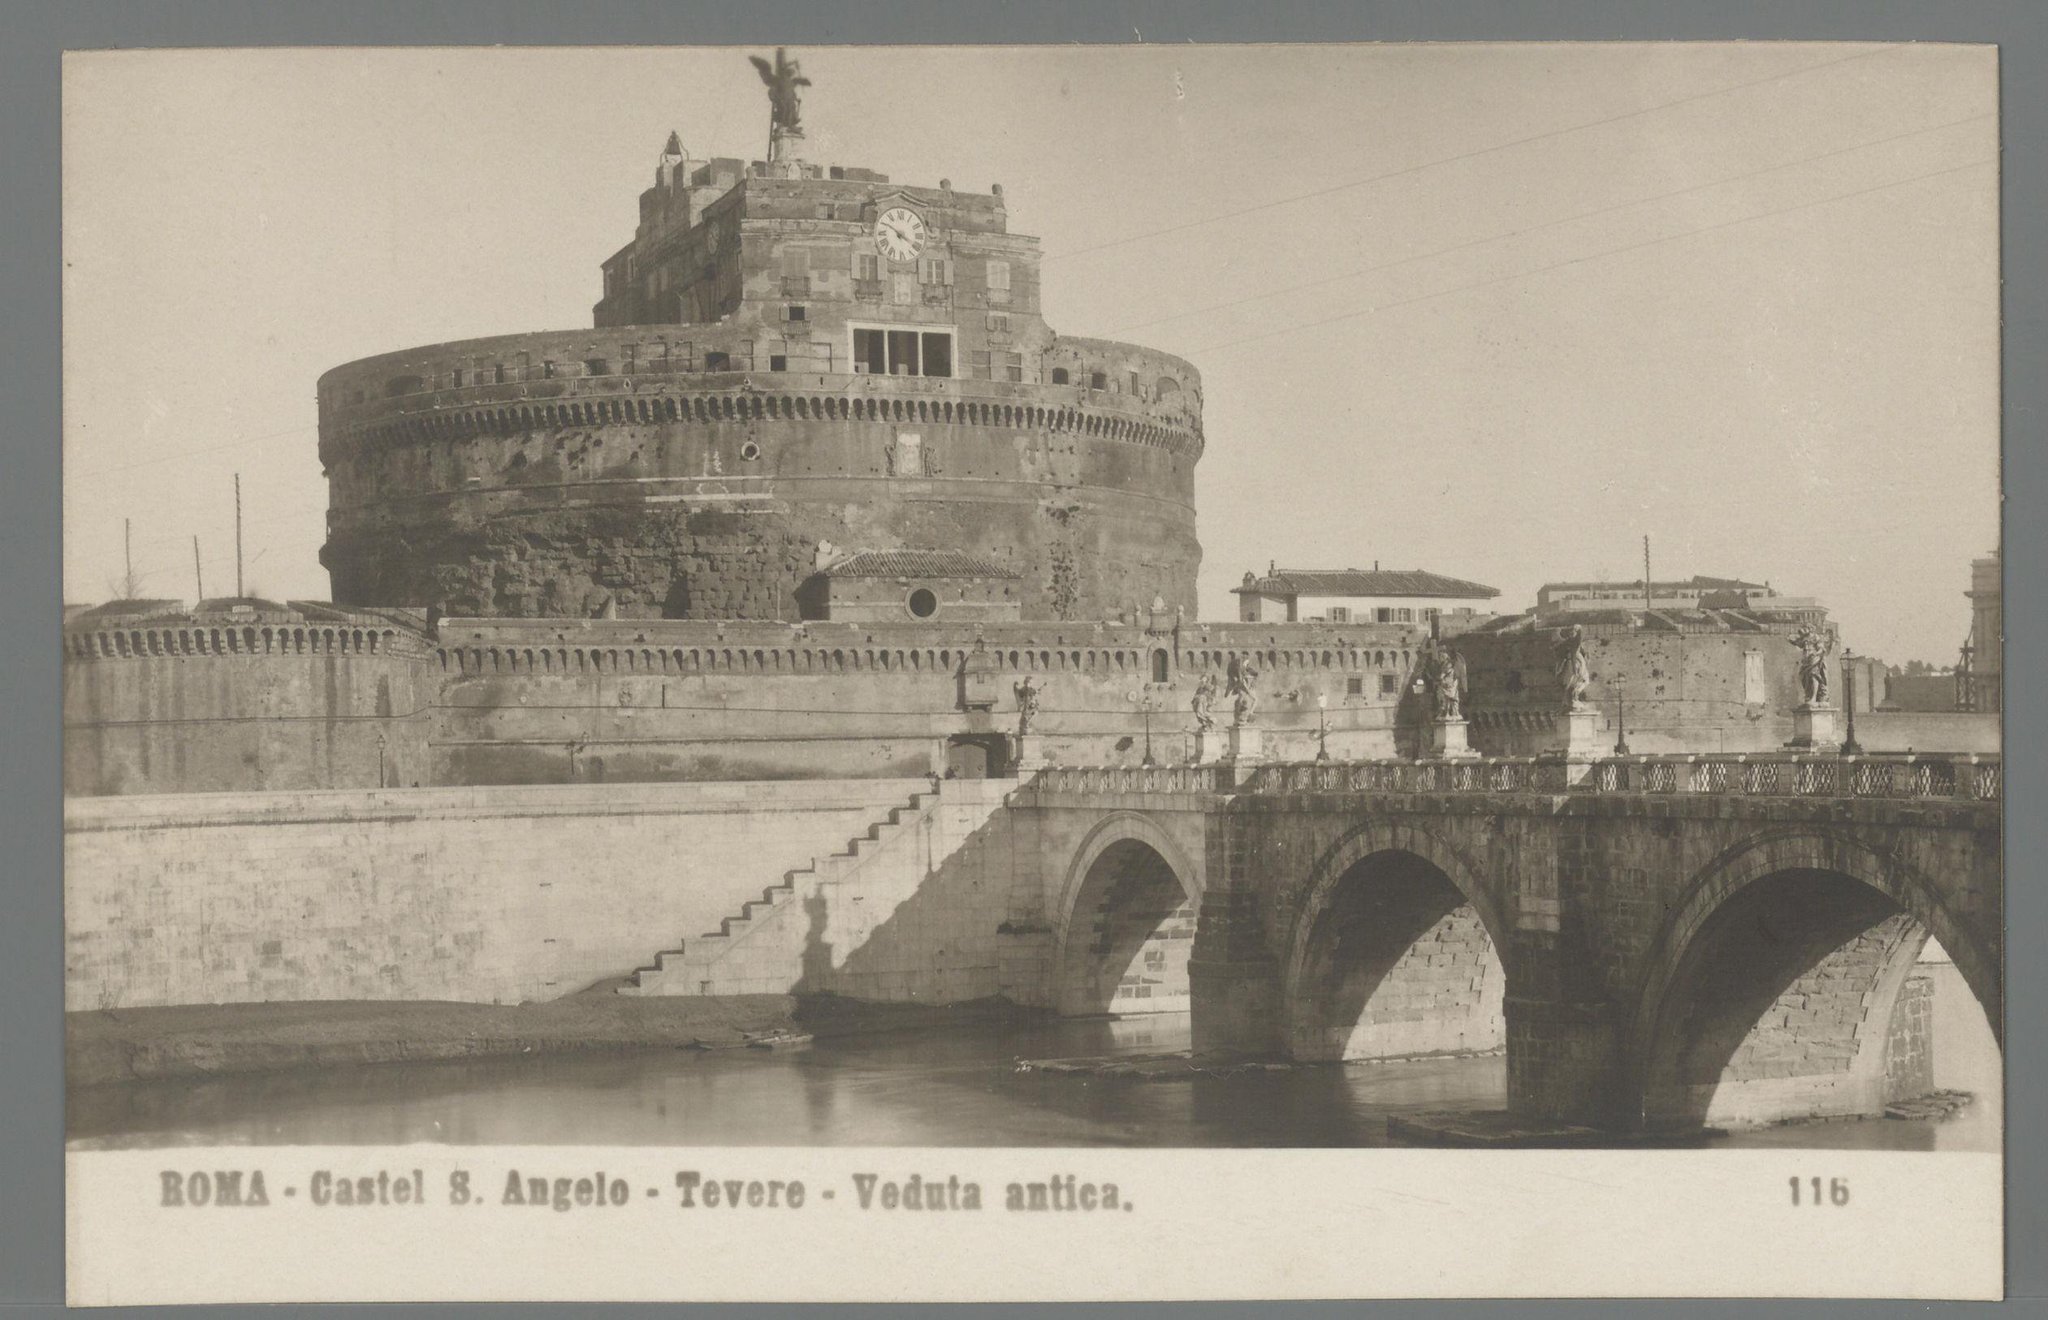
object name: photograph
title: Roma. Castel S. Angelo. Tevere. Veduta antica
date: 1906-1920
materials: photographic support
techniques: photography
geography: milan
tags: fortress, river, bridge